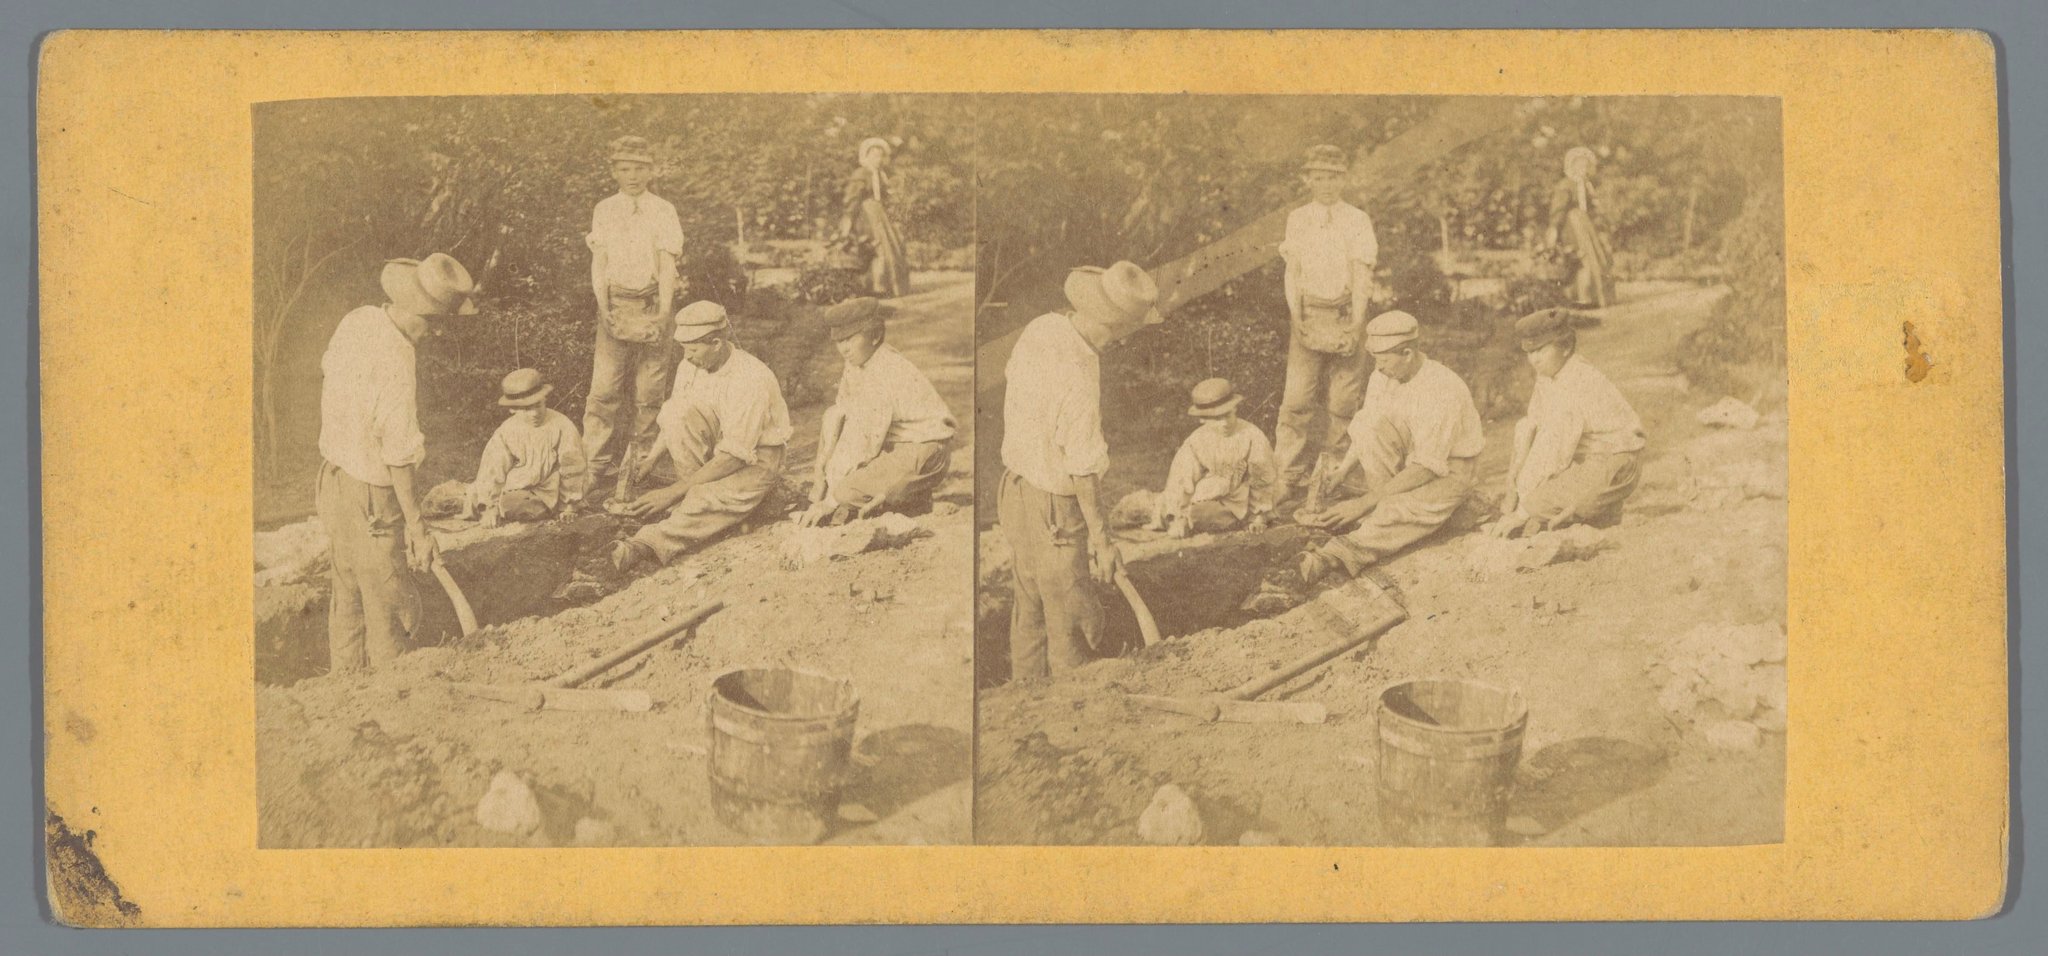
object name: stereograph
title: Mannen en jongens graven in een tuin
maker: Anonymous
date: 1850-1880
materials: cardboard, photographic support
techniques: albumen print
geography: europe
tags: digging (industrial process), europe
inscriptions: number: ‘40377’